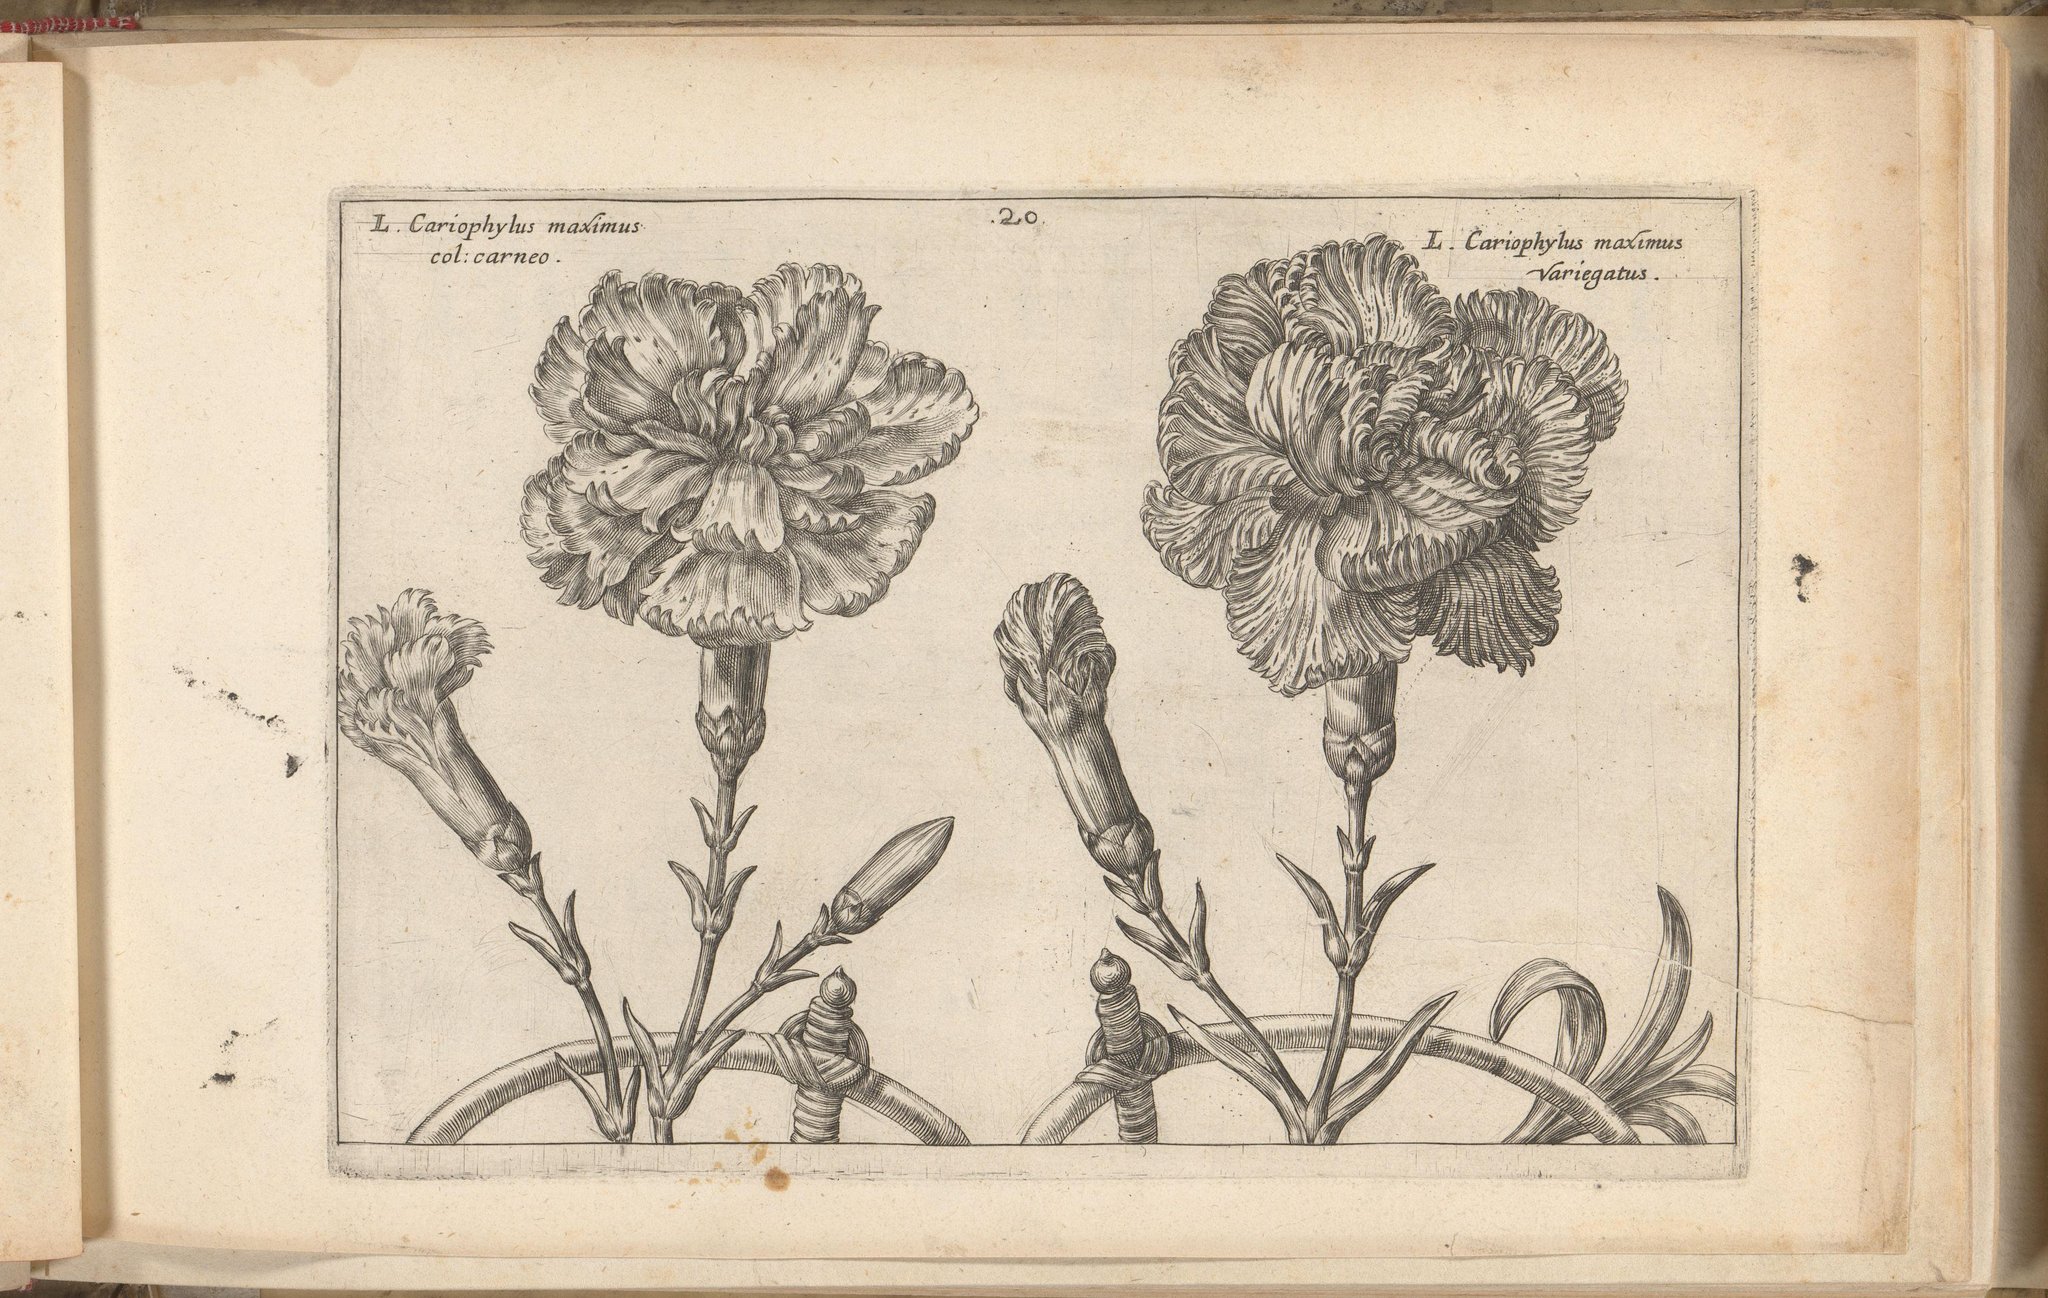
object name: book illustration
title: Bloementuin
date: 1617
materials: paper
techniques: engraving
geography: utrecht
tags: flowers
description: Prent uit: Passe, Crispijn van de (II). Hortus floridus in quo rariorum & minus vulgarium florum icones ad vivam veramque formam. Arnhem: Johannes Janssonius, 1617.